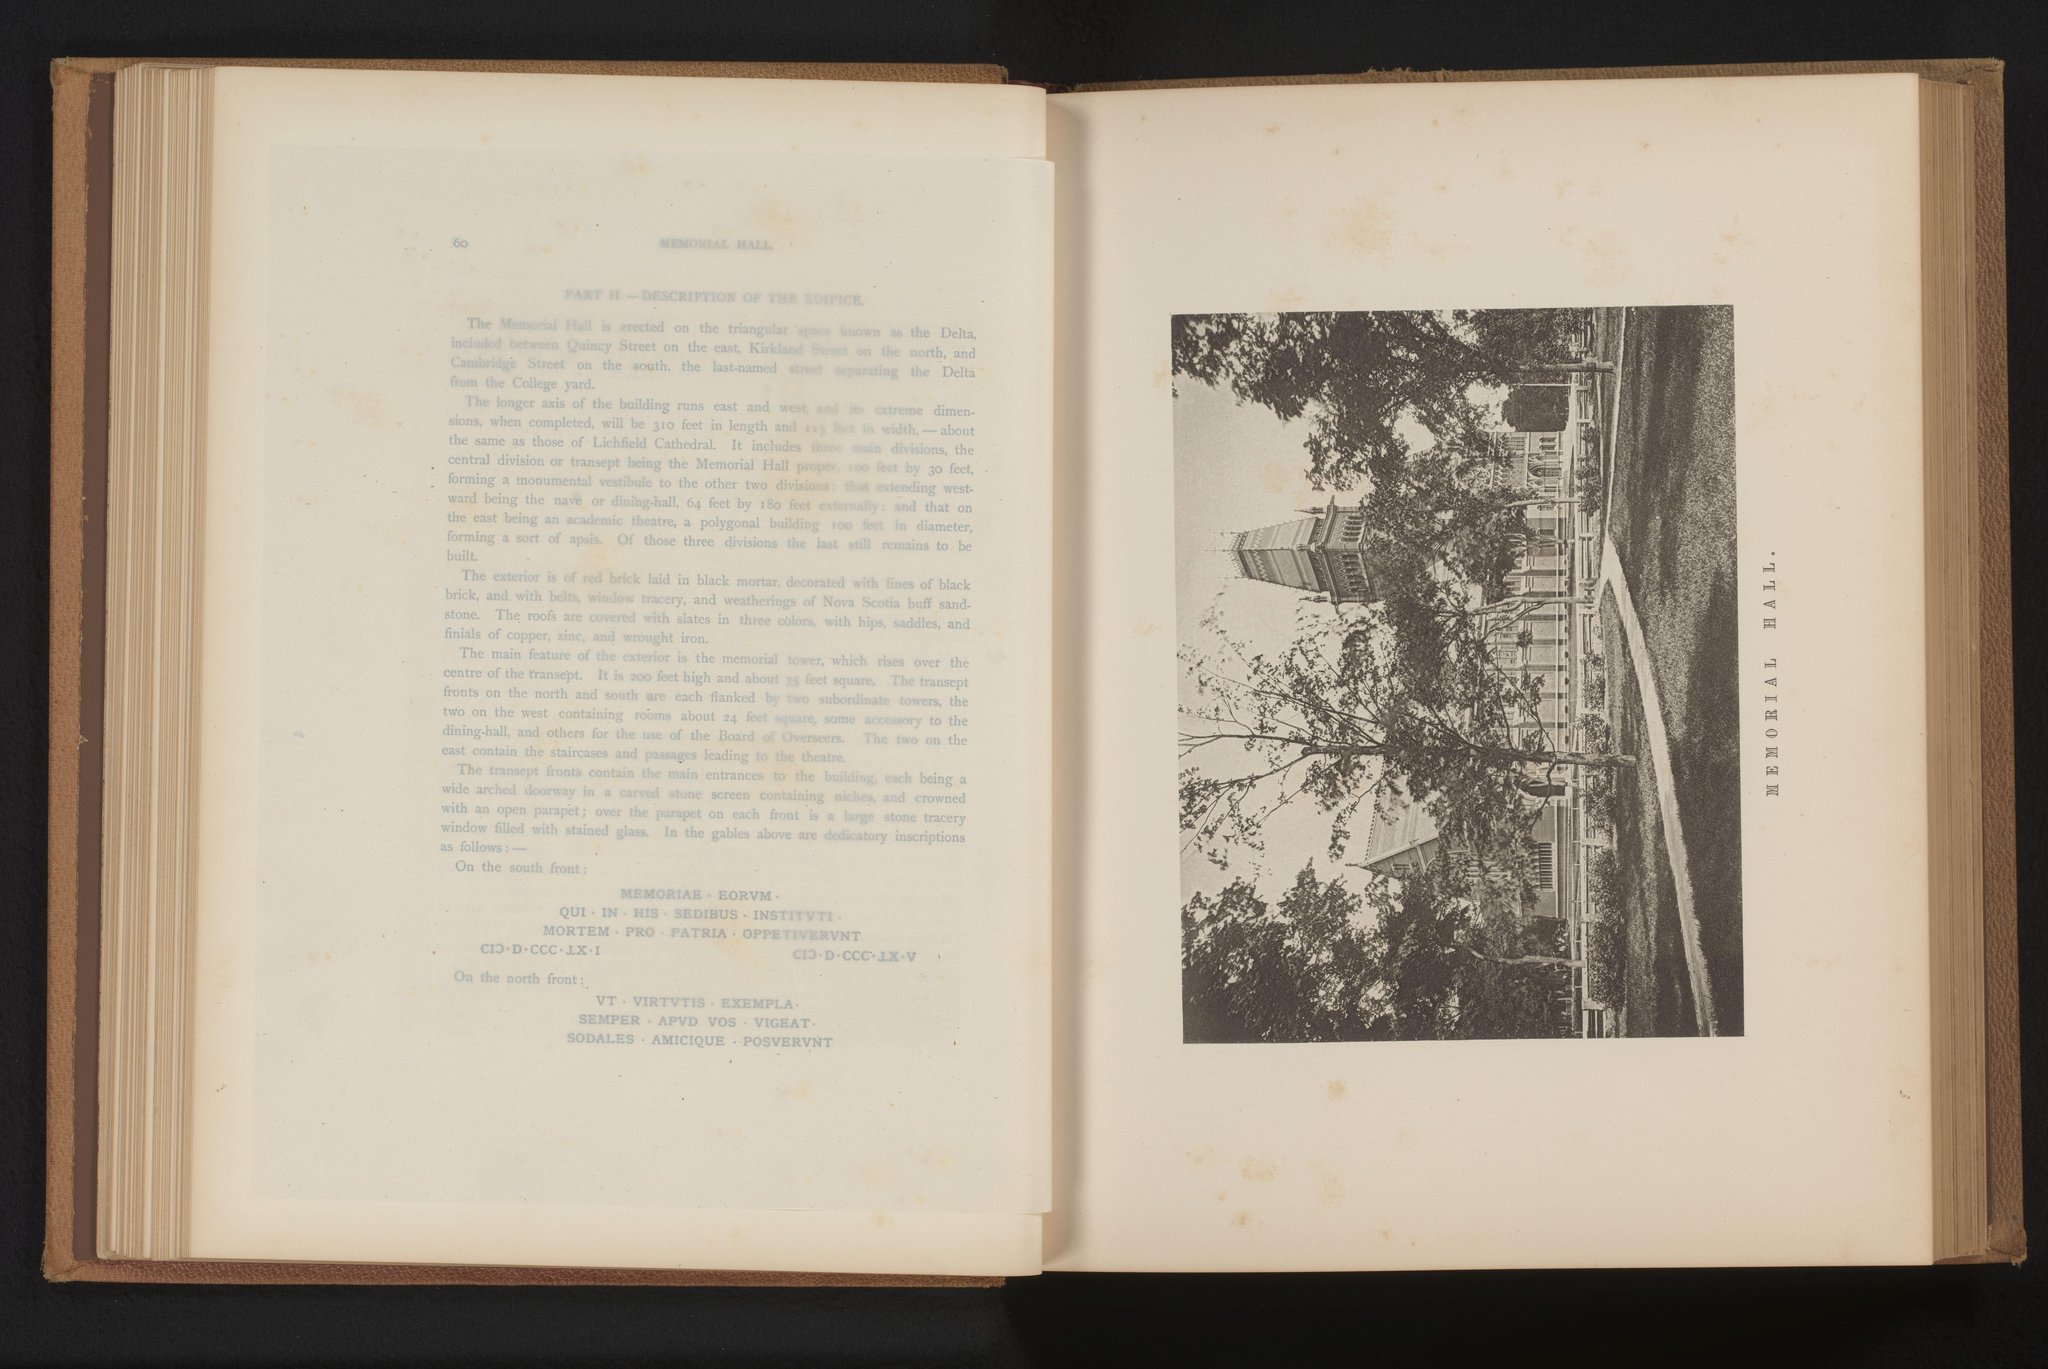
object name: photomechanical print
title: Memorial Hall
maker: Anonymous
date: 1870-1875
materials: paper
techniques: photograph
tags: university building, college